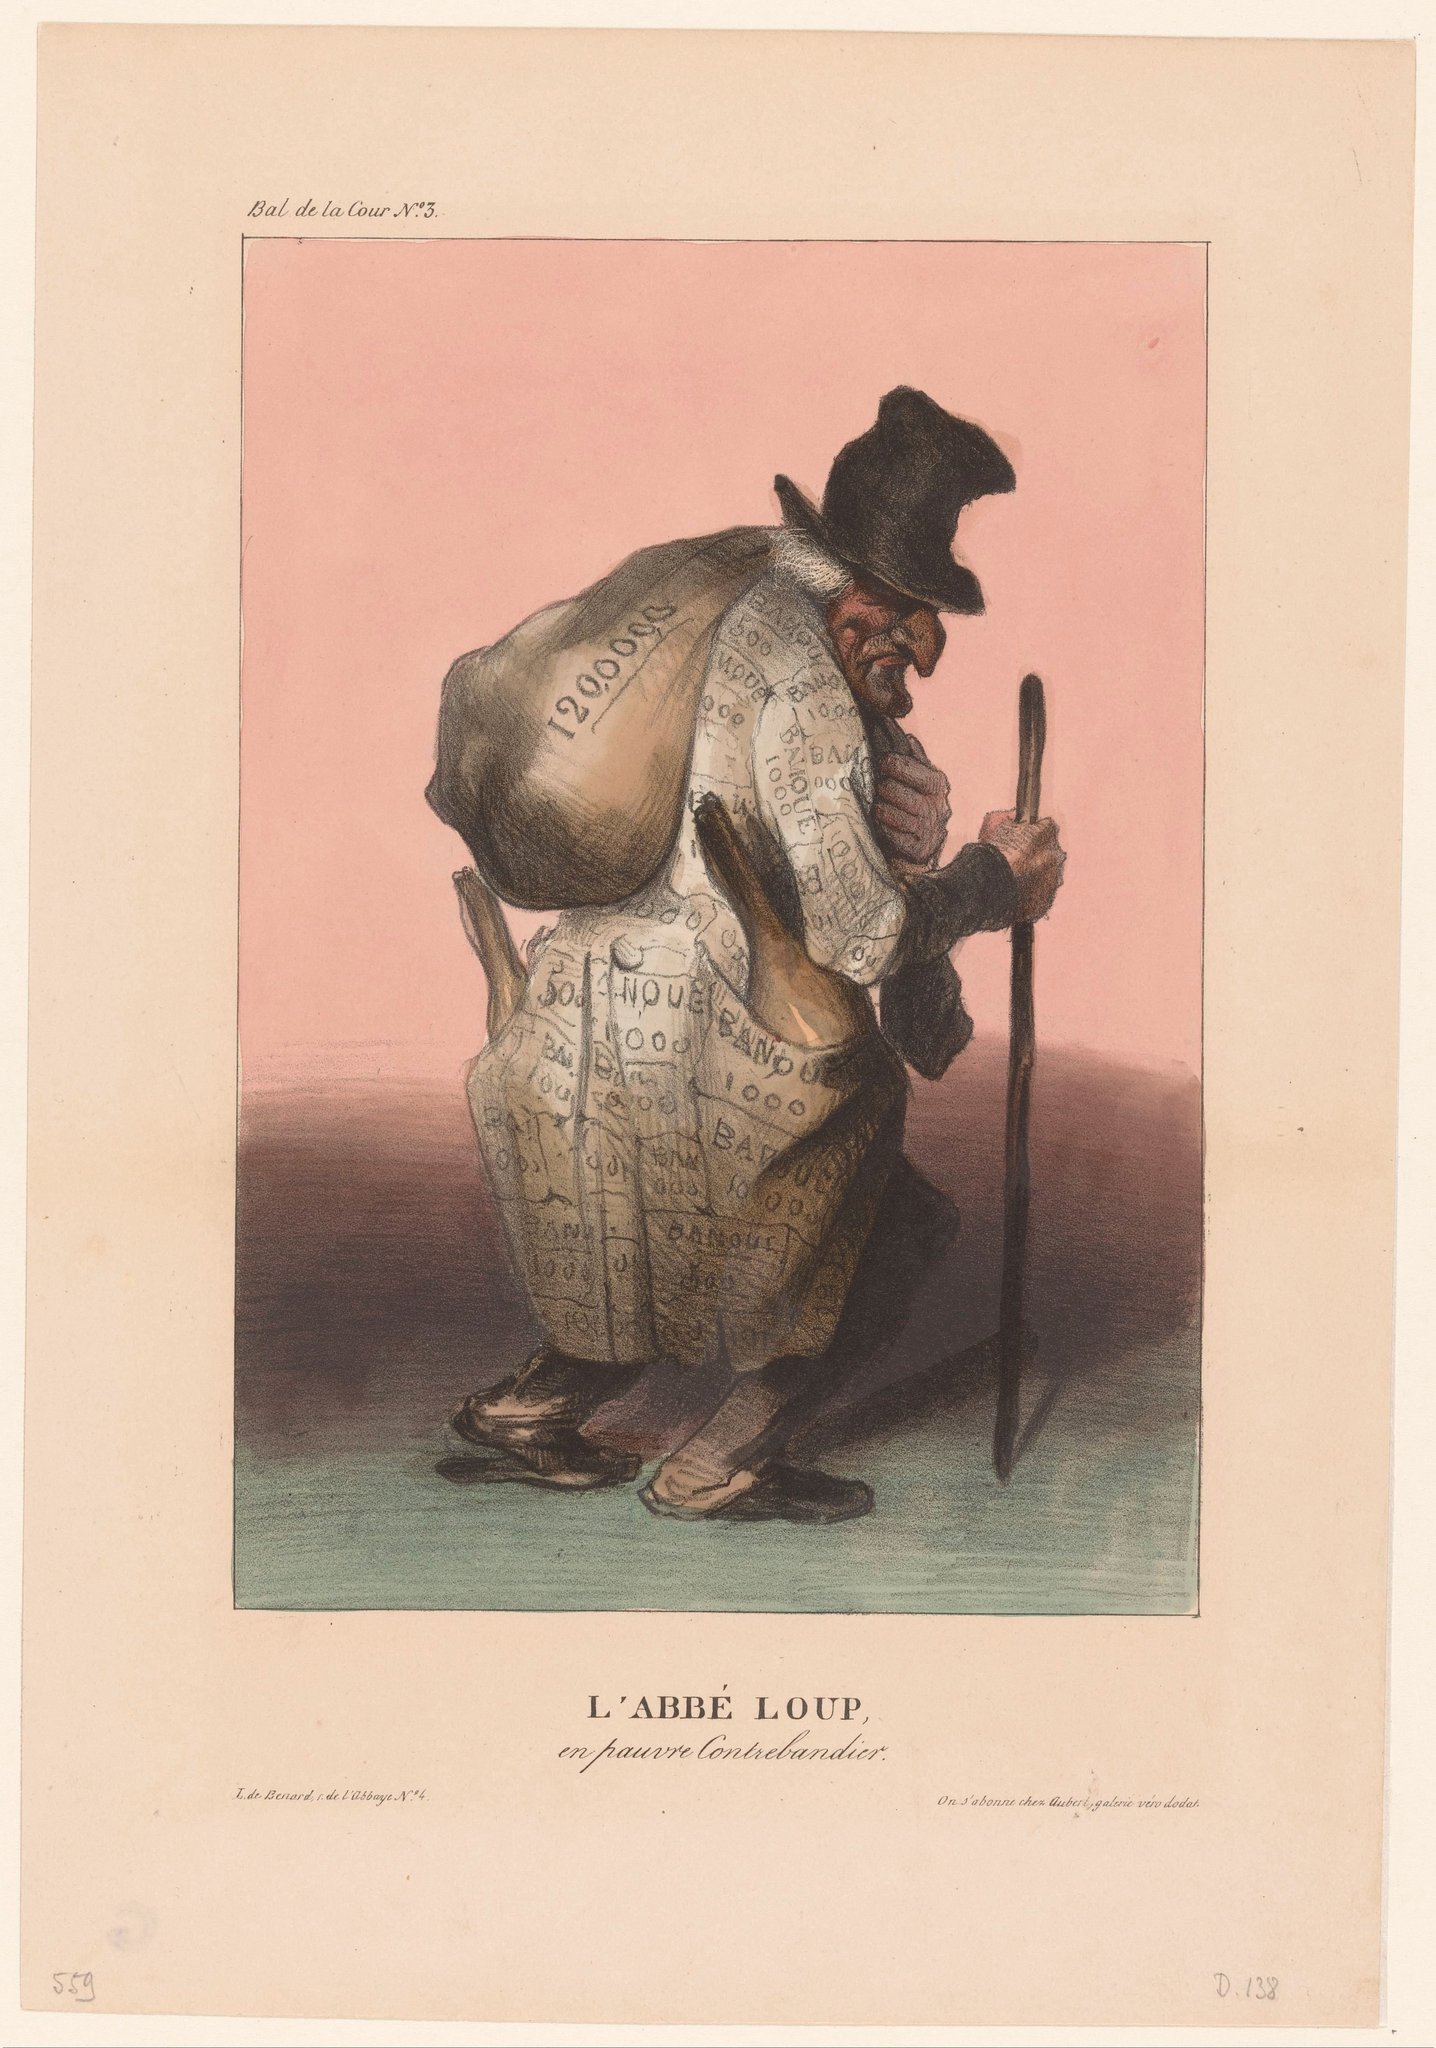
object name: cartoon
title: Machtsvertoon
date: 1833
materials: paper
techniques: hand coloring, lithograph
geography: paris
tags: caricatures (human types), historical persons, political caricatures and satires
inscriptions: collector's mark: Lugt 2228a, collector's mark: Lugt 538d, number: ‘559’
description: Prent mogelijk uit: Le Charivari 2 (1833), 13 februari 1833.